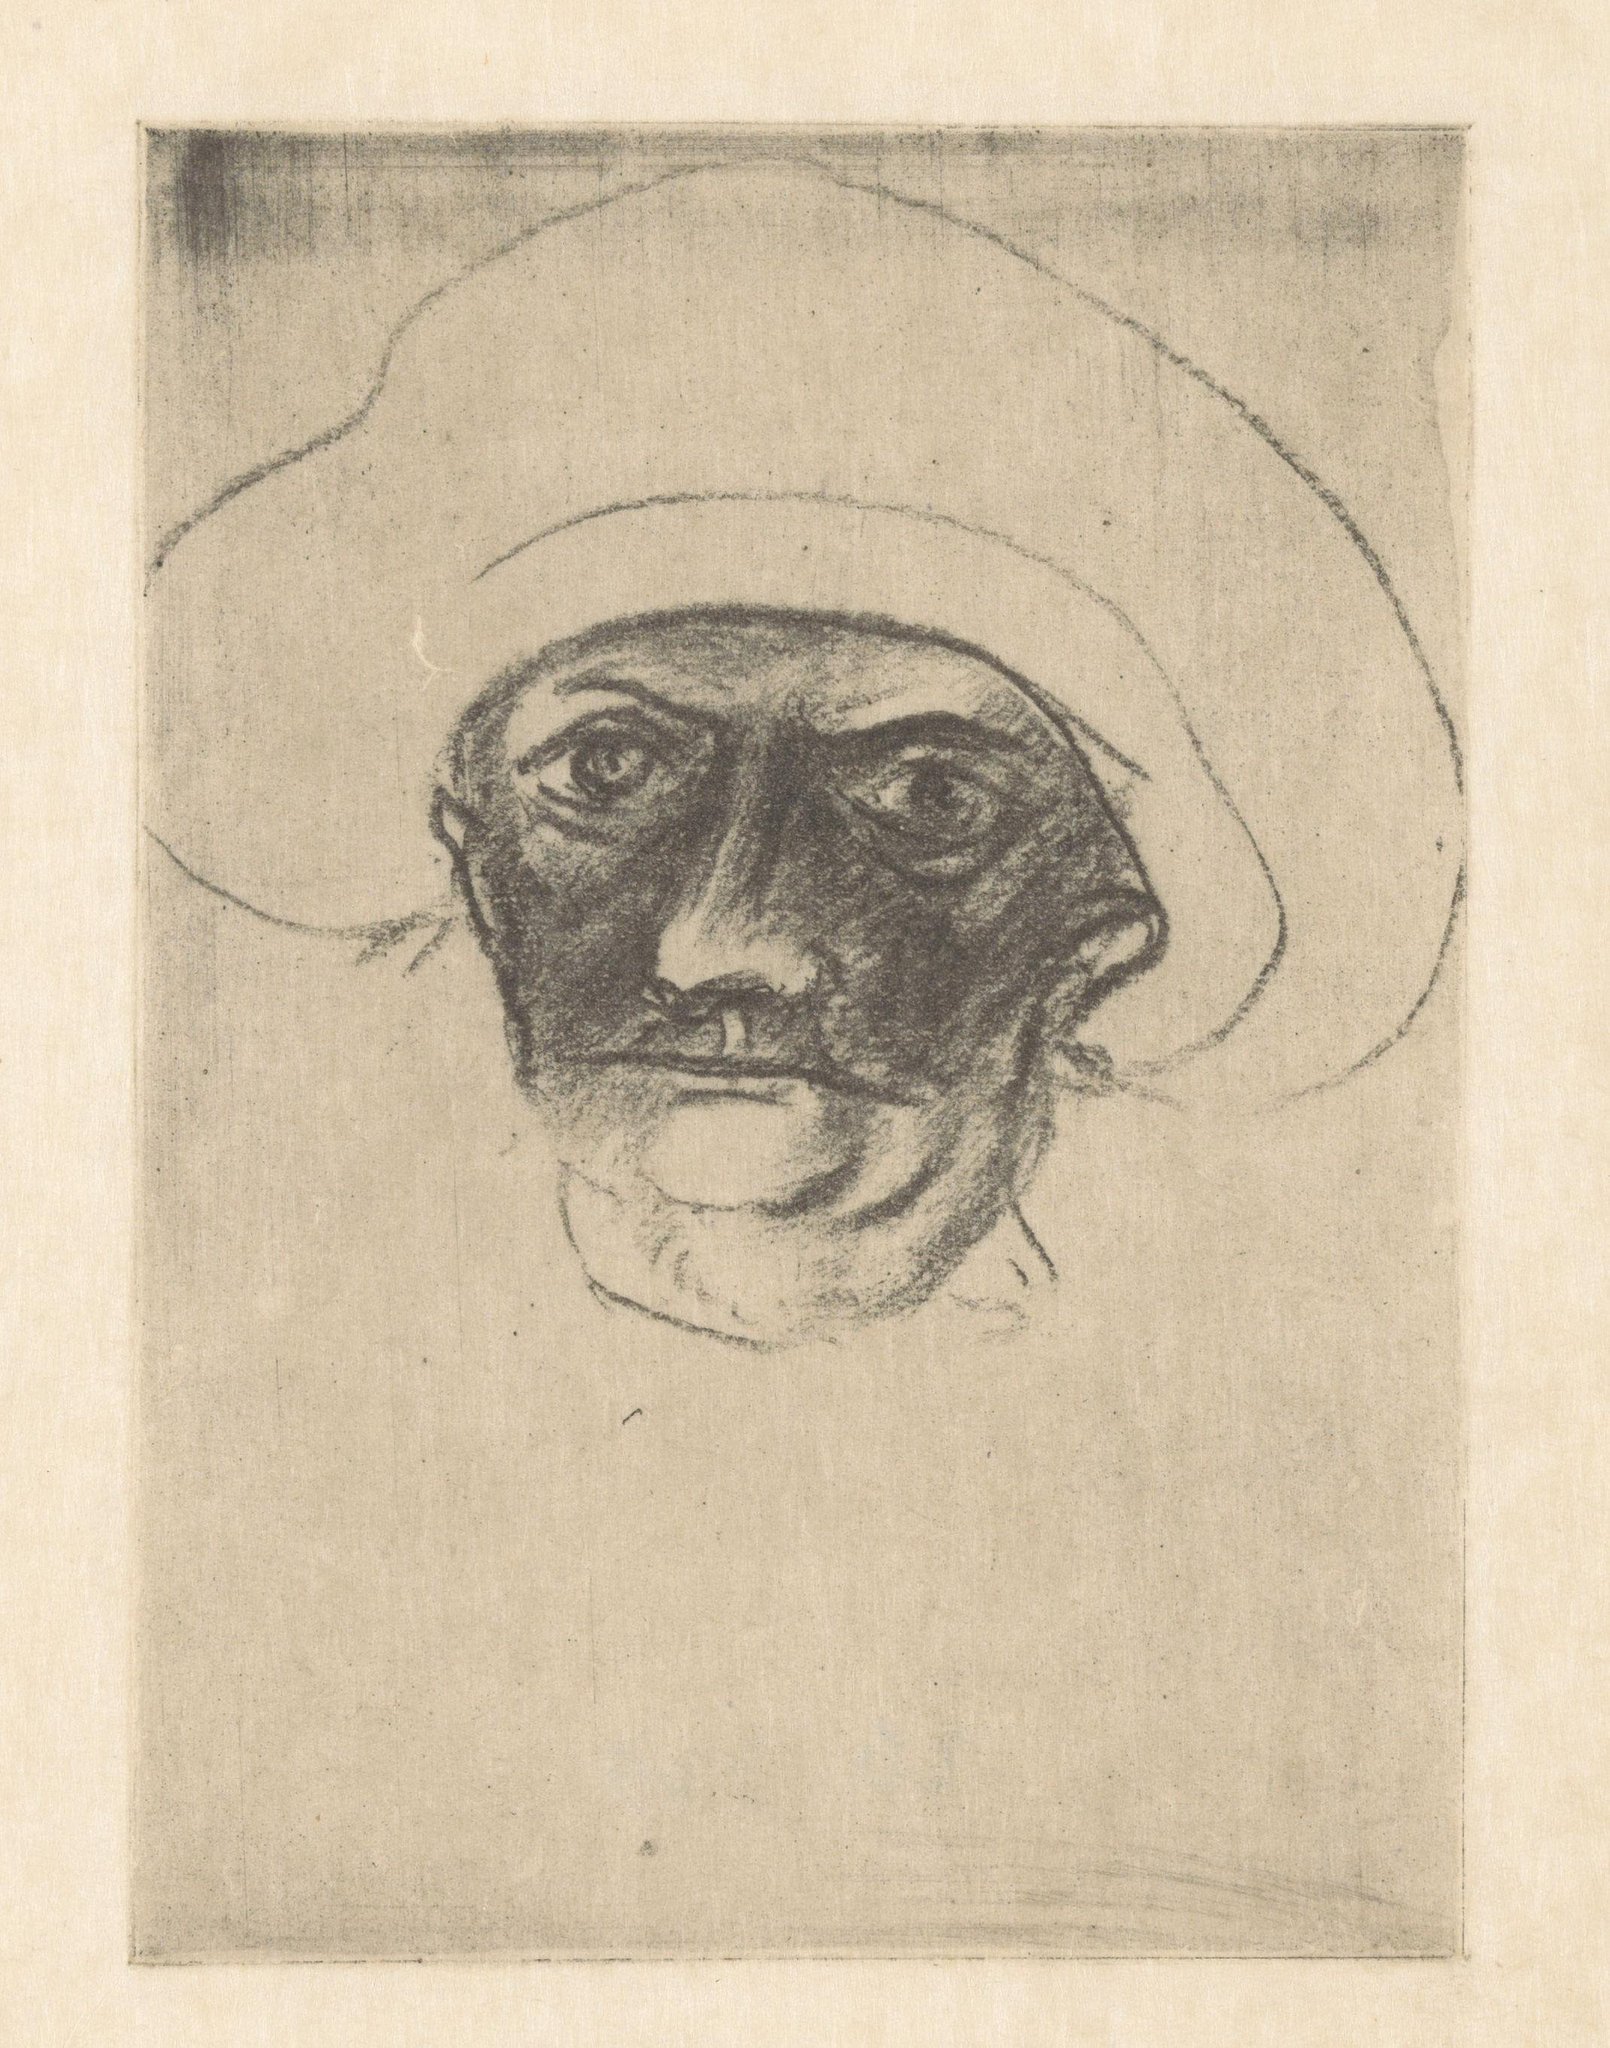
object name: print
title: Man met brede hoed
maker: marius holleman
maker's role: draughtsman, print maker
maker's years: 1878-1926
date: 1904-1926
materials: paper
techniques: etching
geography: groningen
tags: adult man, head-gear: hat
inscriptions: collector's mark: Lugt 2228